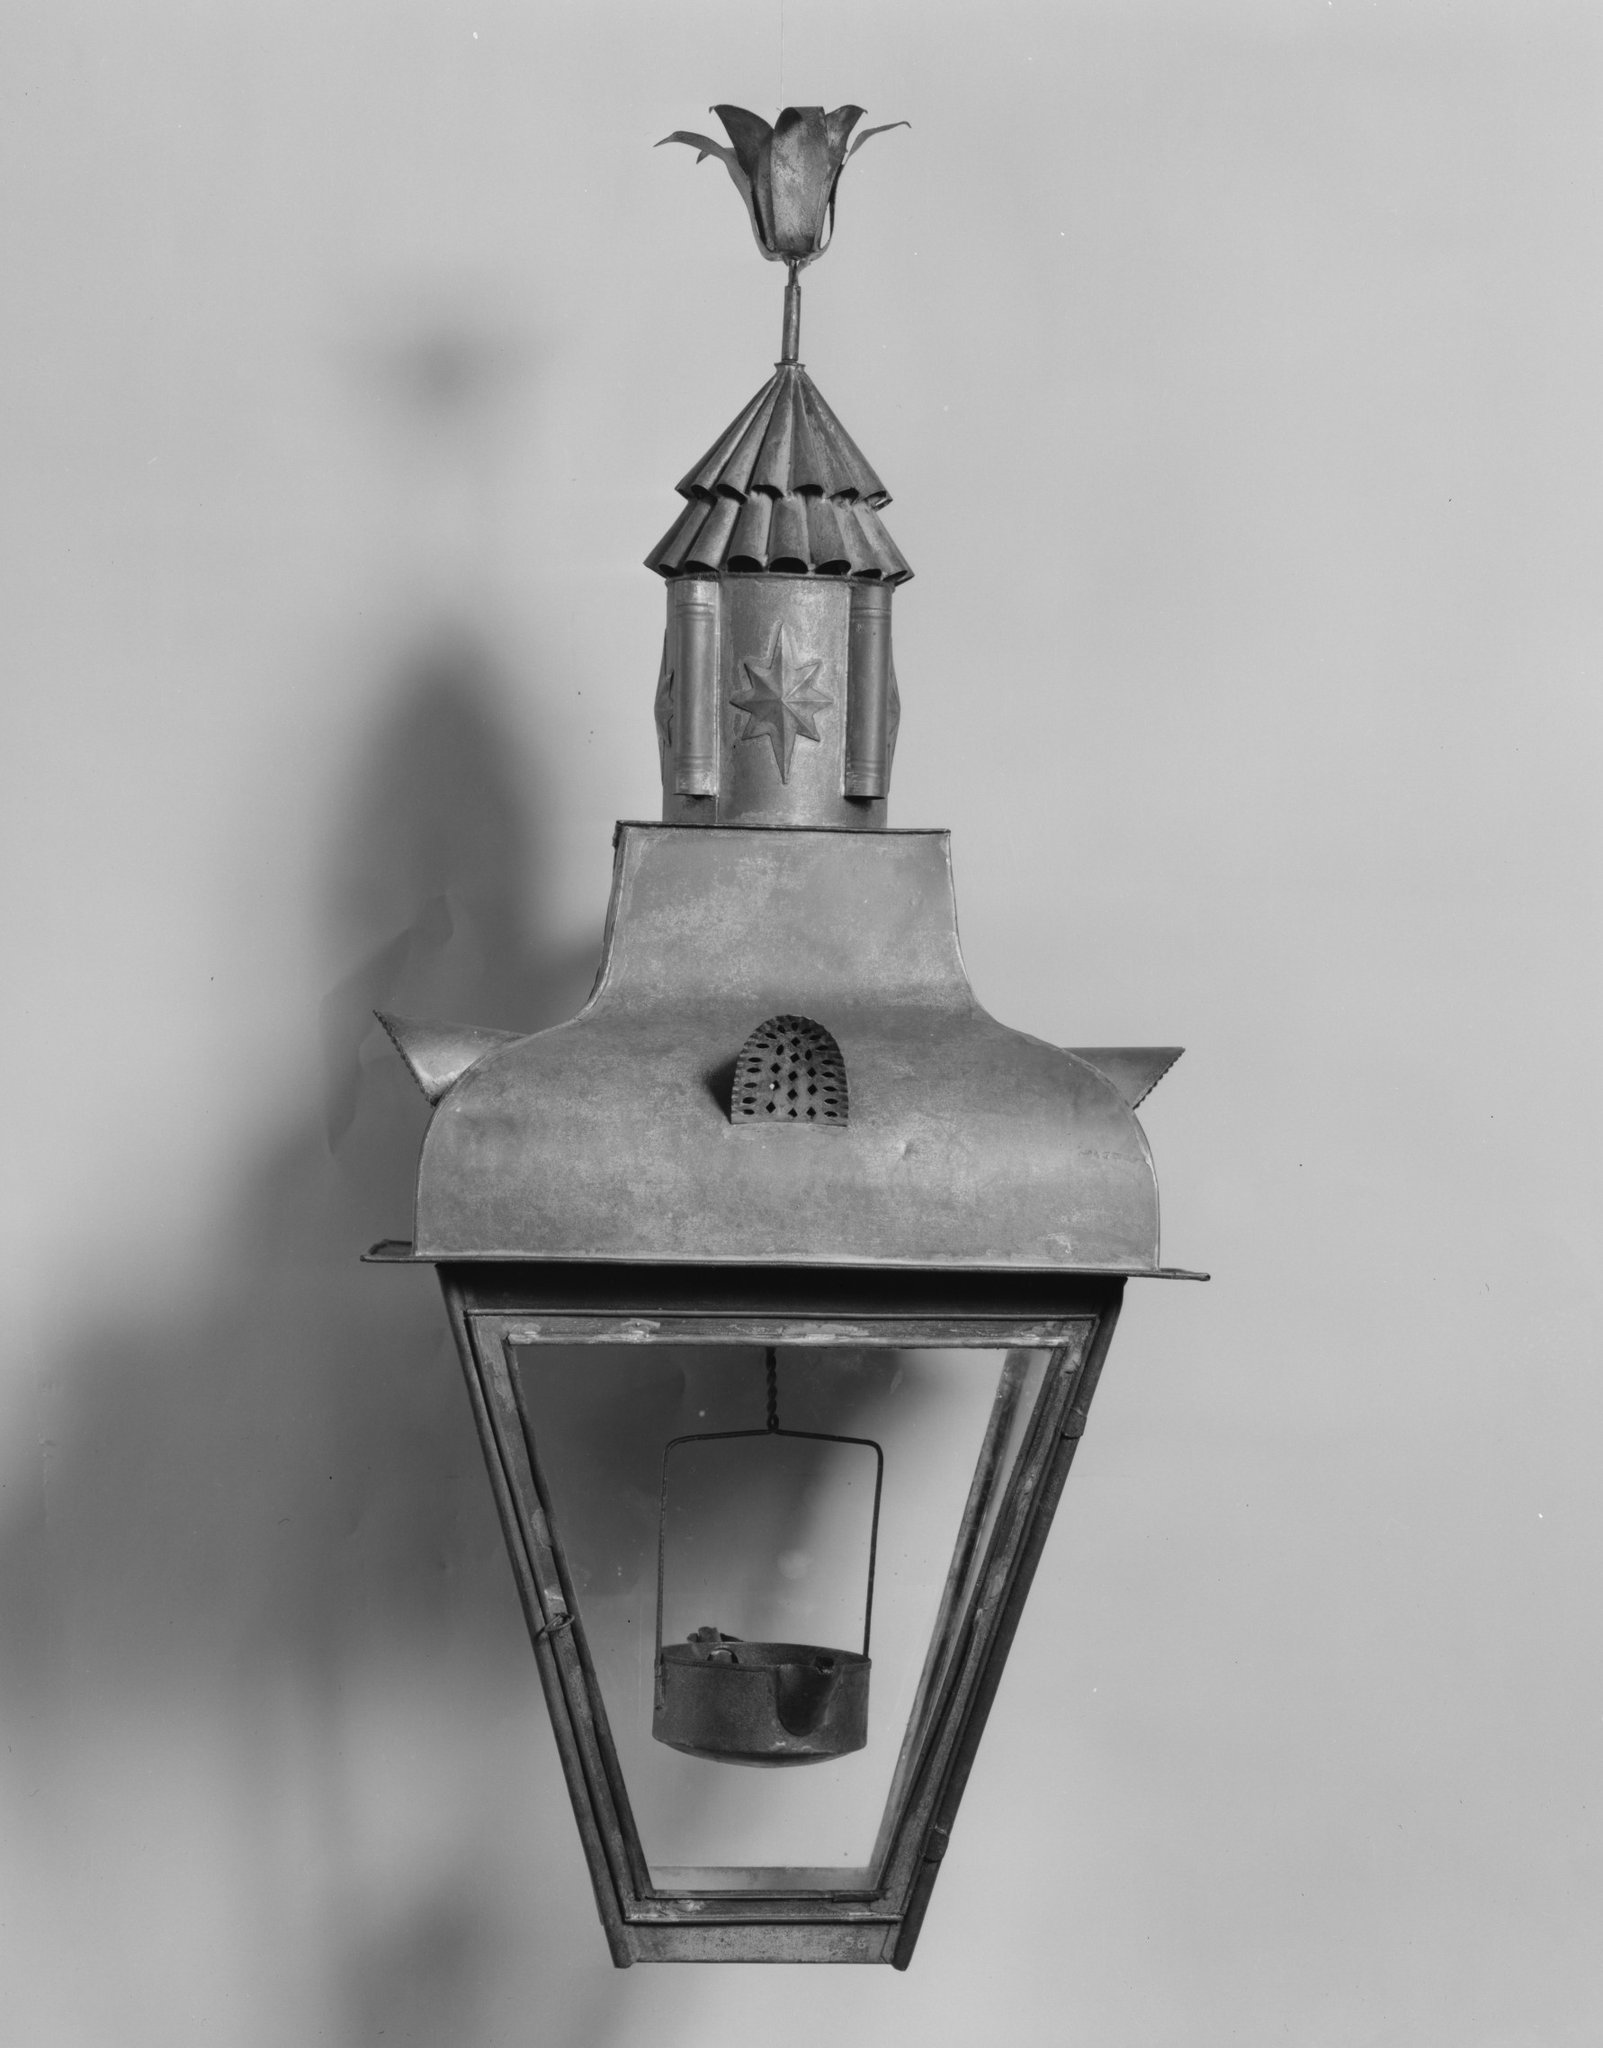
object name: lantern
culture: american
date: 1700-1800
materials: tin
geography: united states